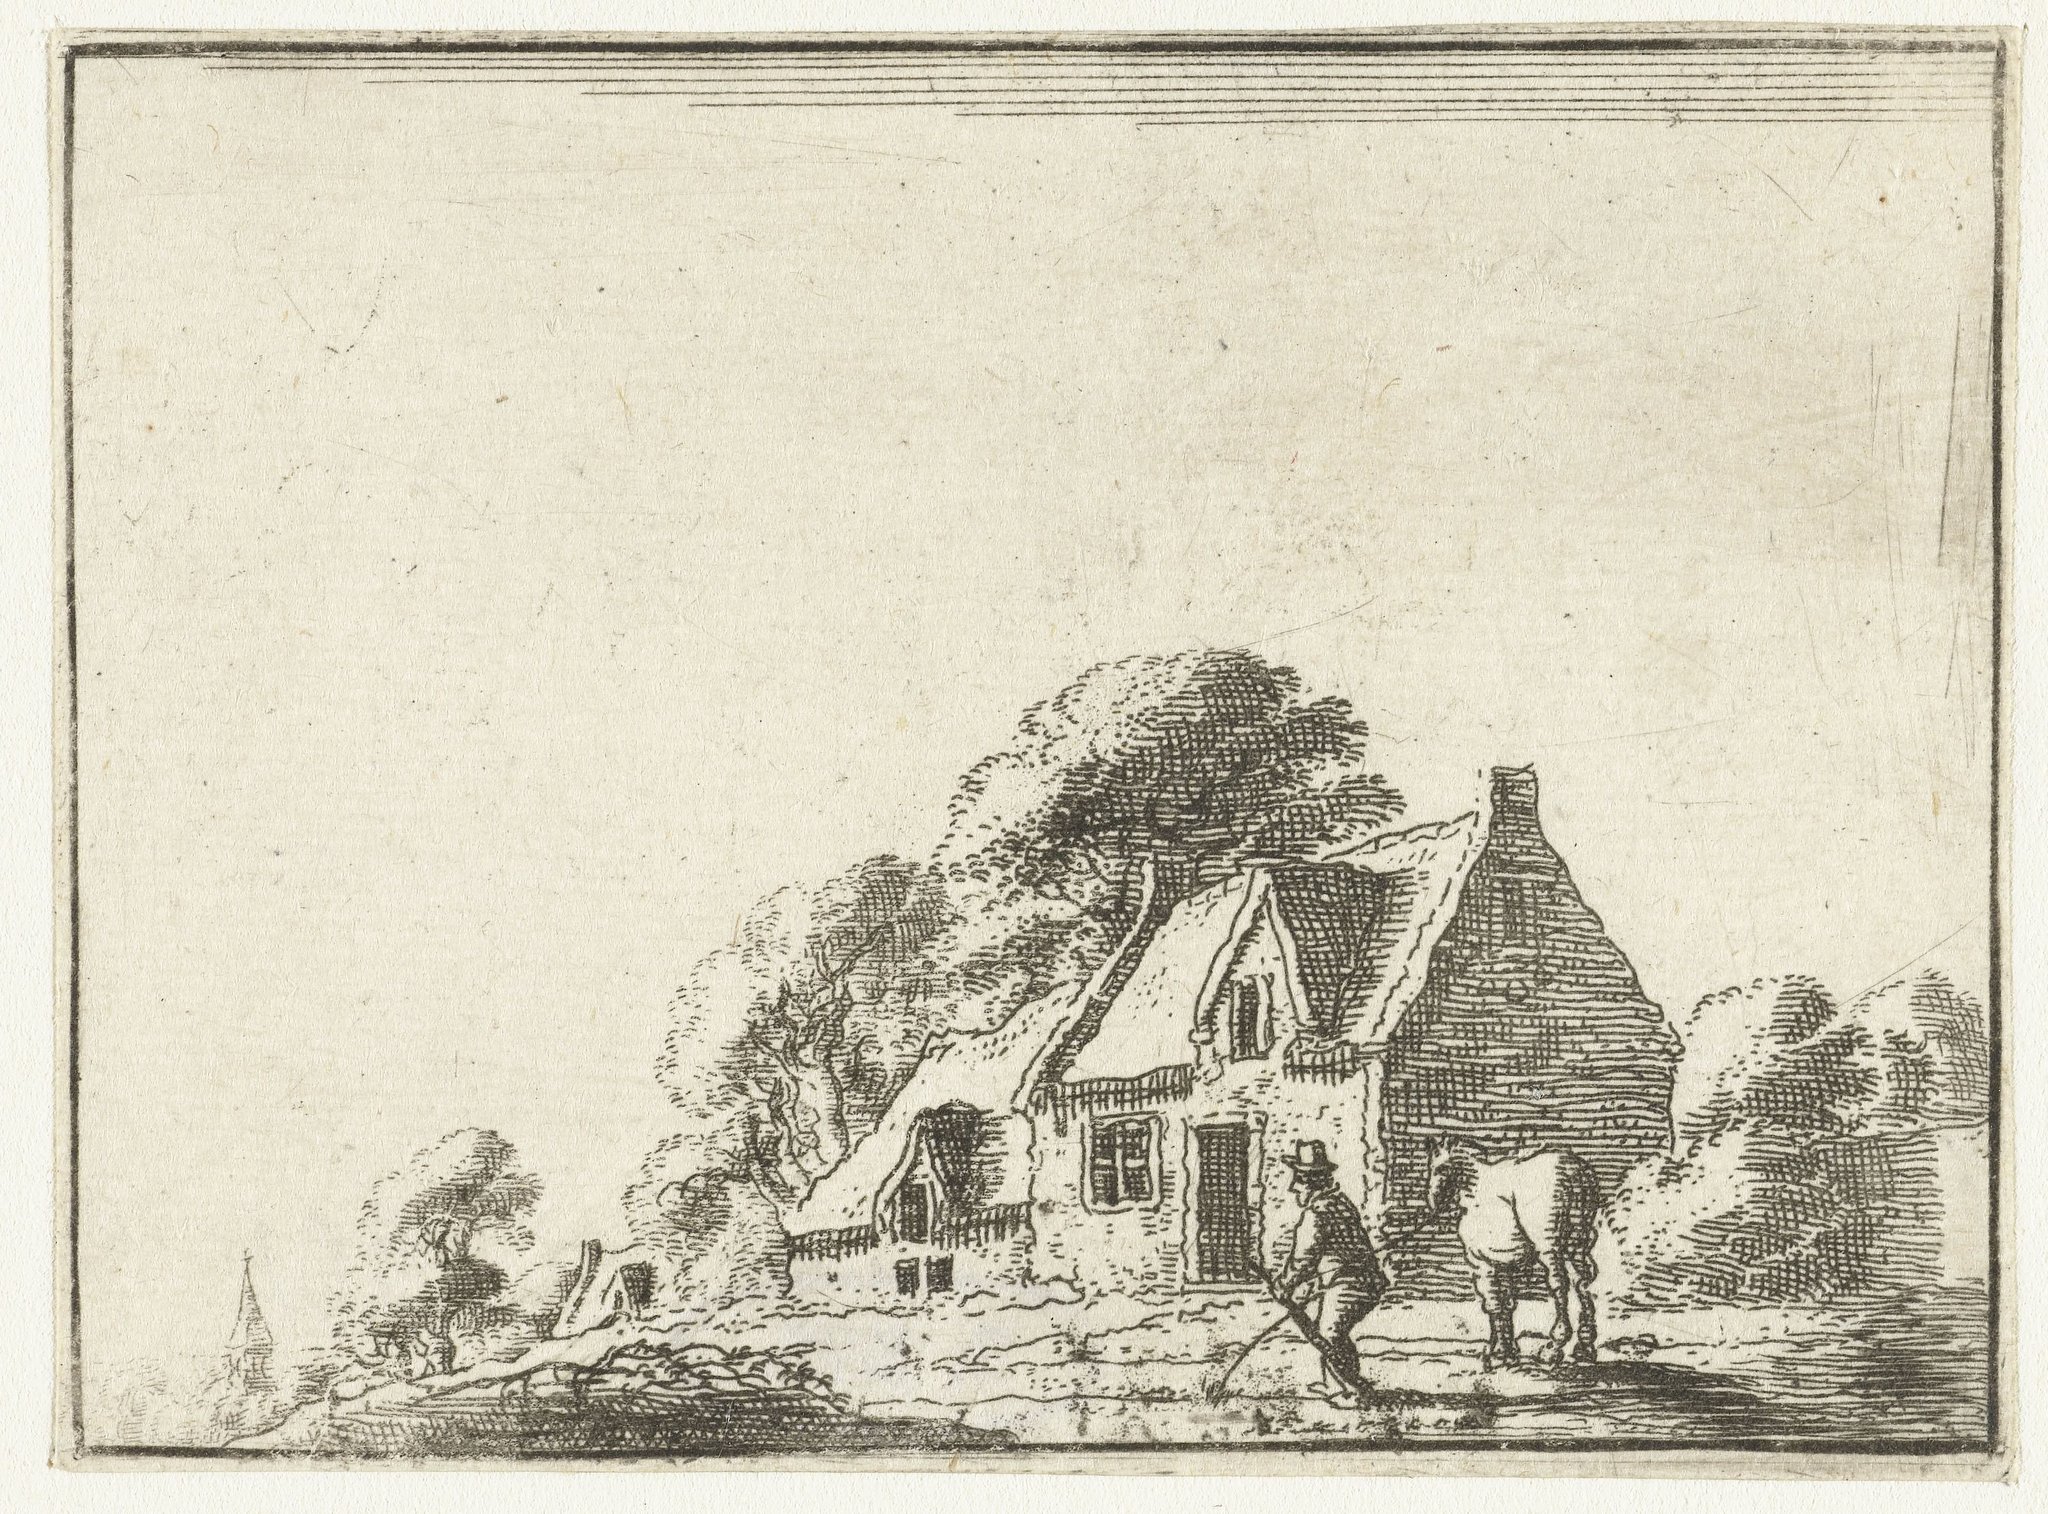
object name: print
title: Landschap met een boerderij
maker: gilles neyts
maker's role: draughtsman, print maker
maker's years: 1623-1687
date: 1643-1681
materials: paper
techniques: etching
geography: antwerp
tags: farm or solitary house in landscape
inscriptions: collector's mark: Lugt 2228a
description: Een boerderij met bomen ernaast. Op de voorgrond een boer en een paard.